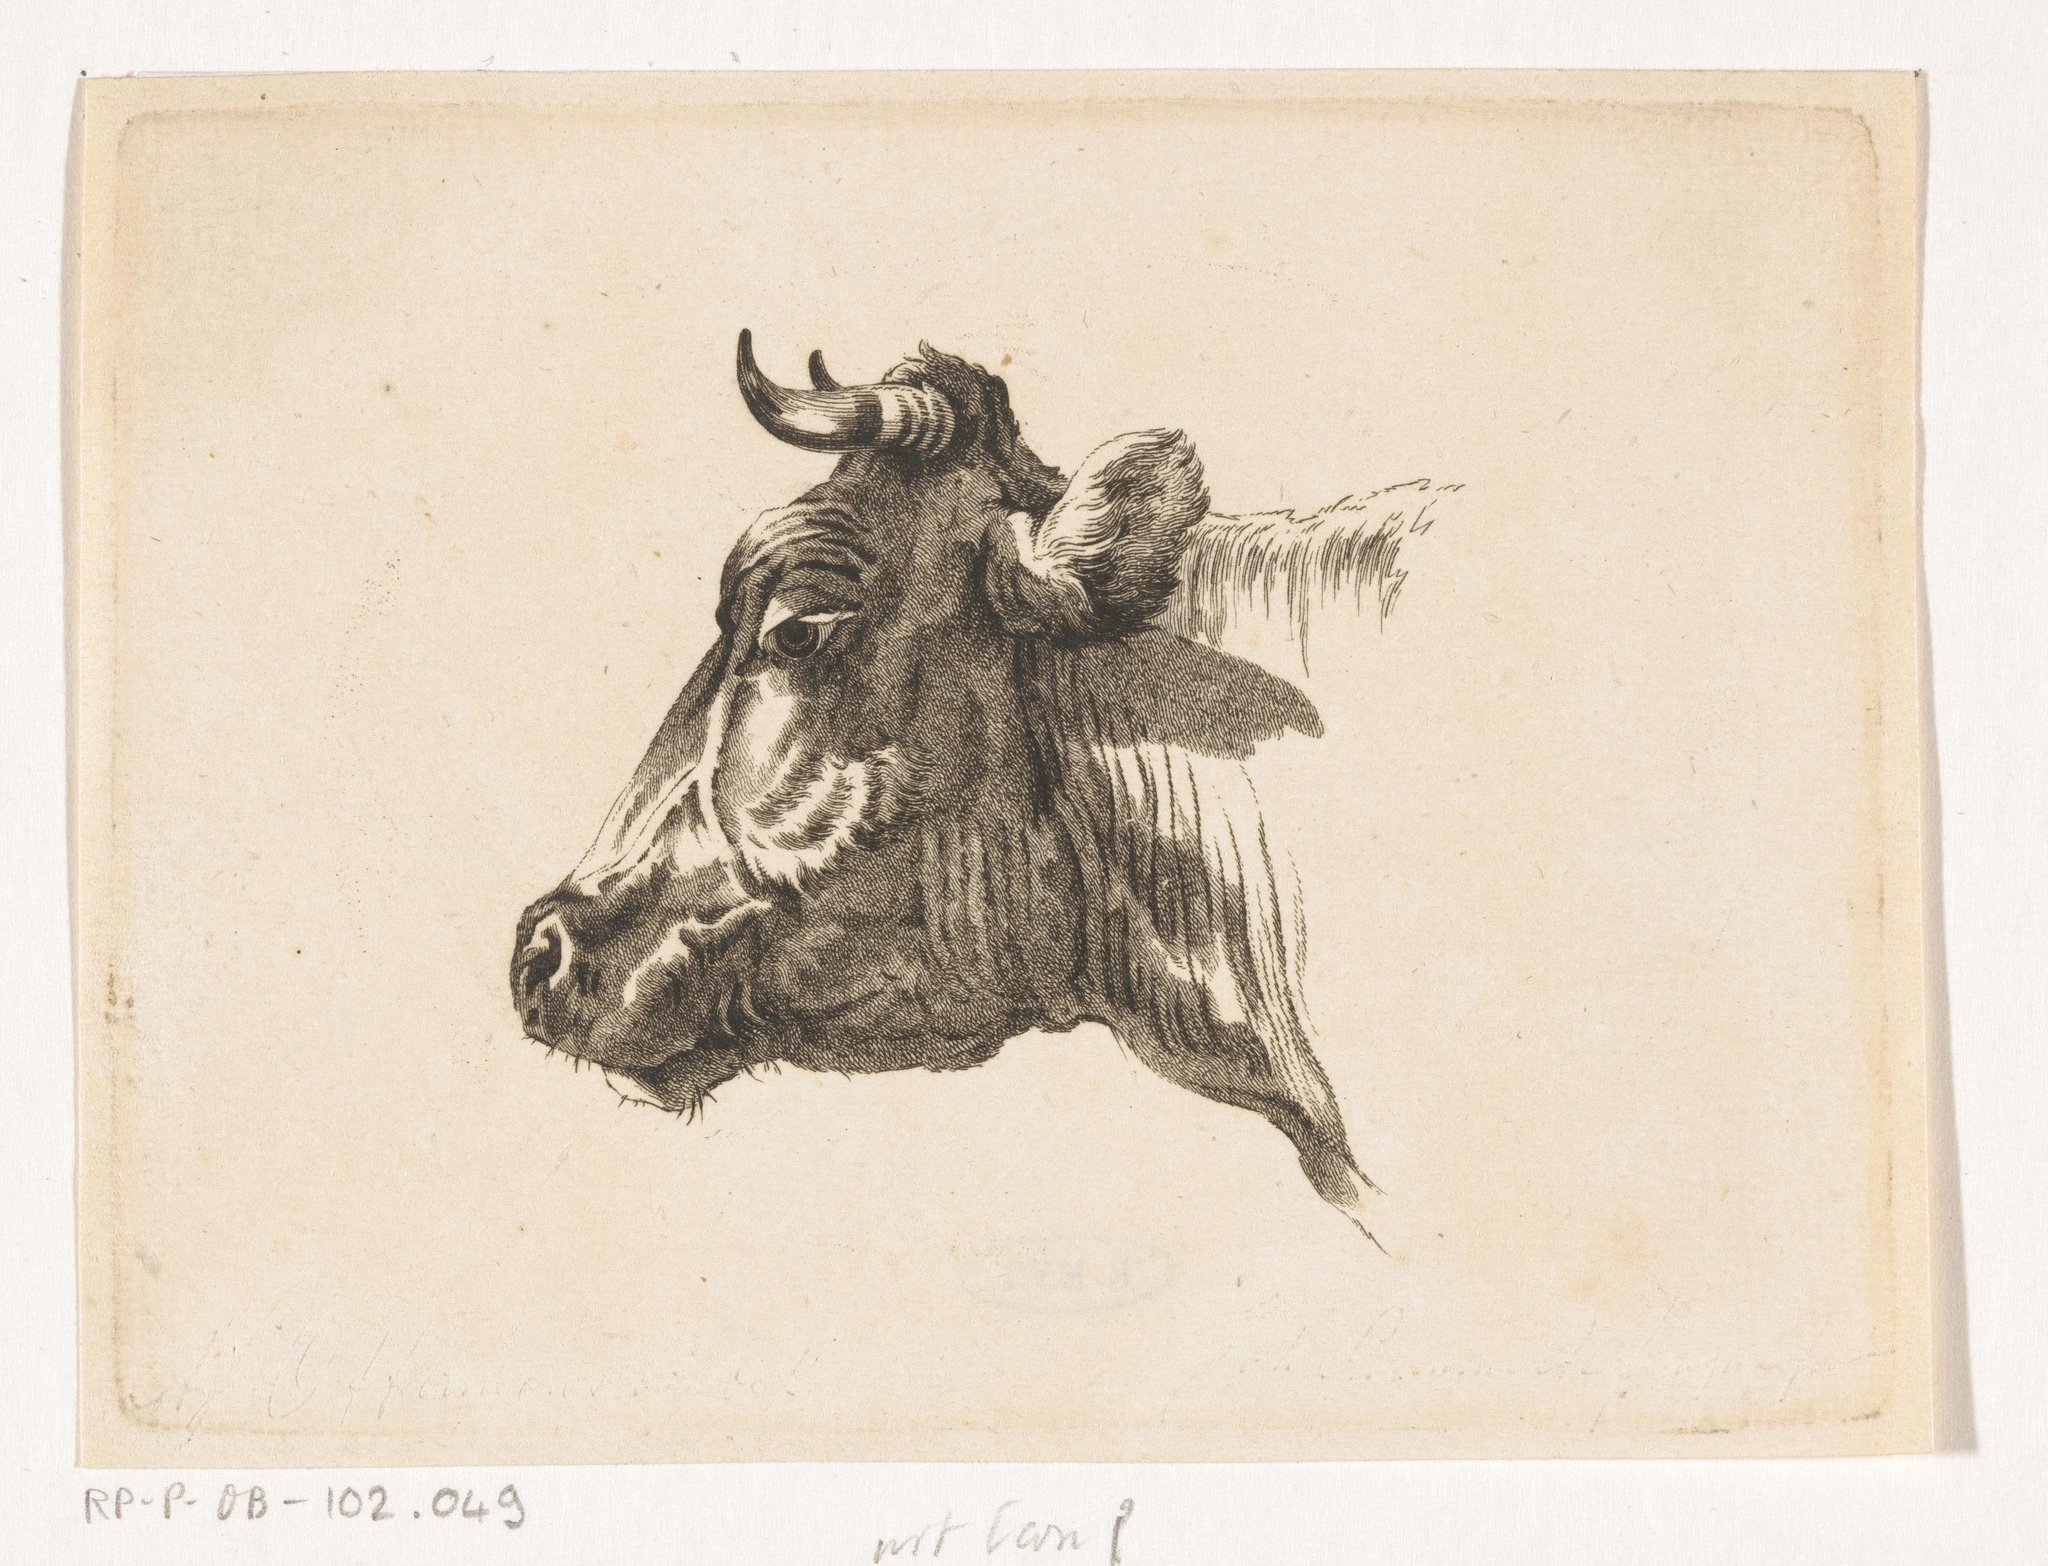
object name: print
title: Koeienkop naar links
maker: joannes bemme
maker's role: print maker, printer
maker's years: 1775-1841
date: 1800-1841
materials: paper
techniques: etching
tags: cow (+ head of an animal)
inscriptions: collector's mark: Lugt 2228